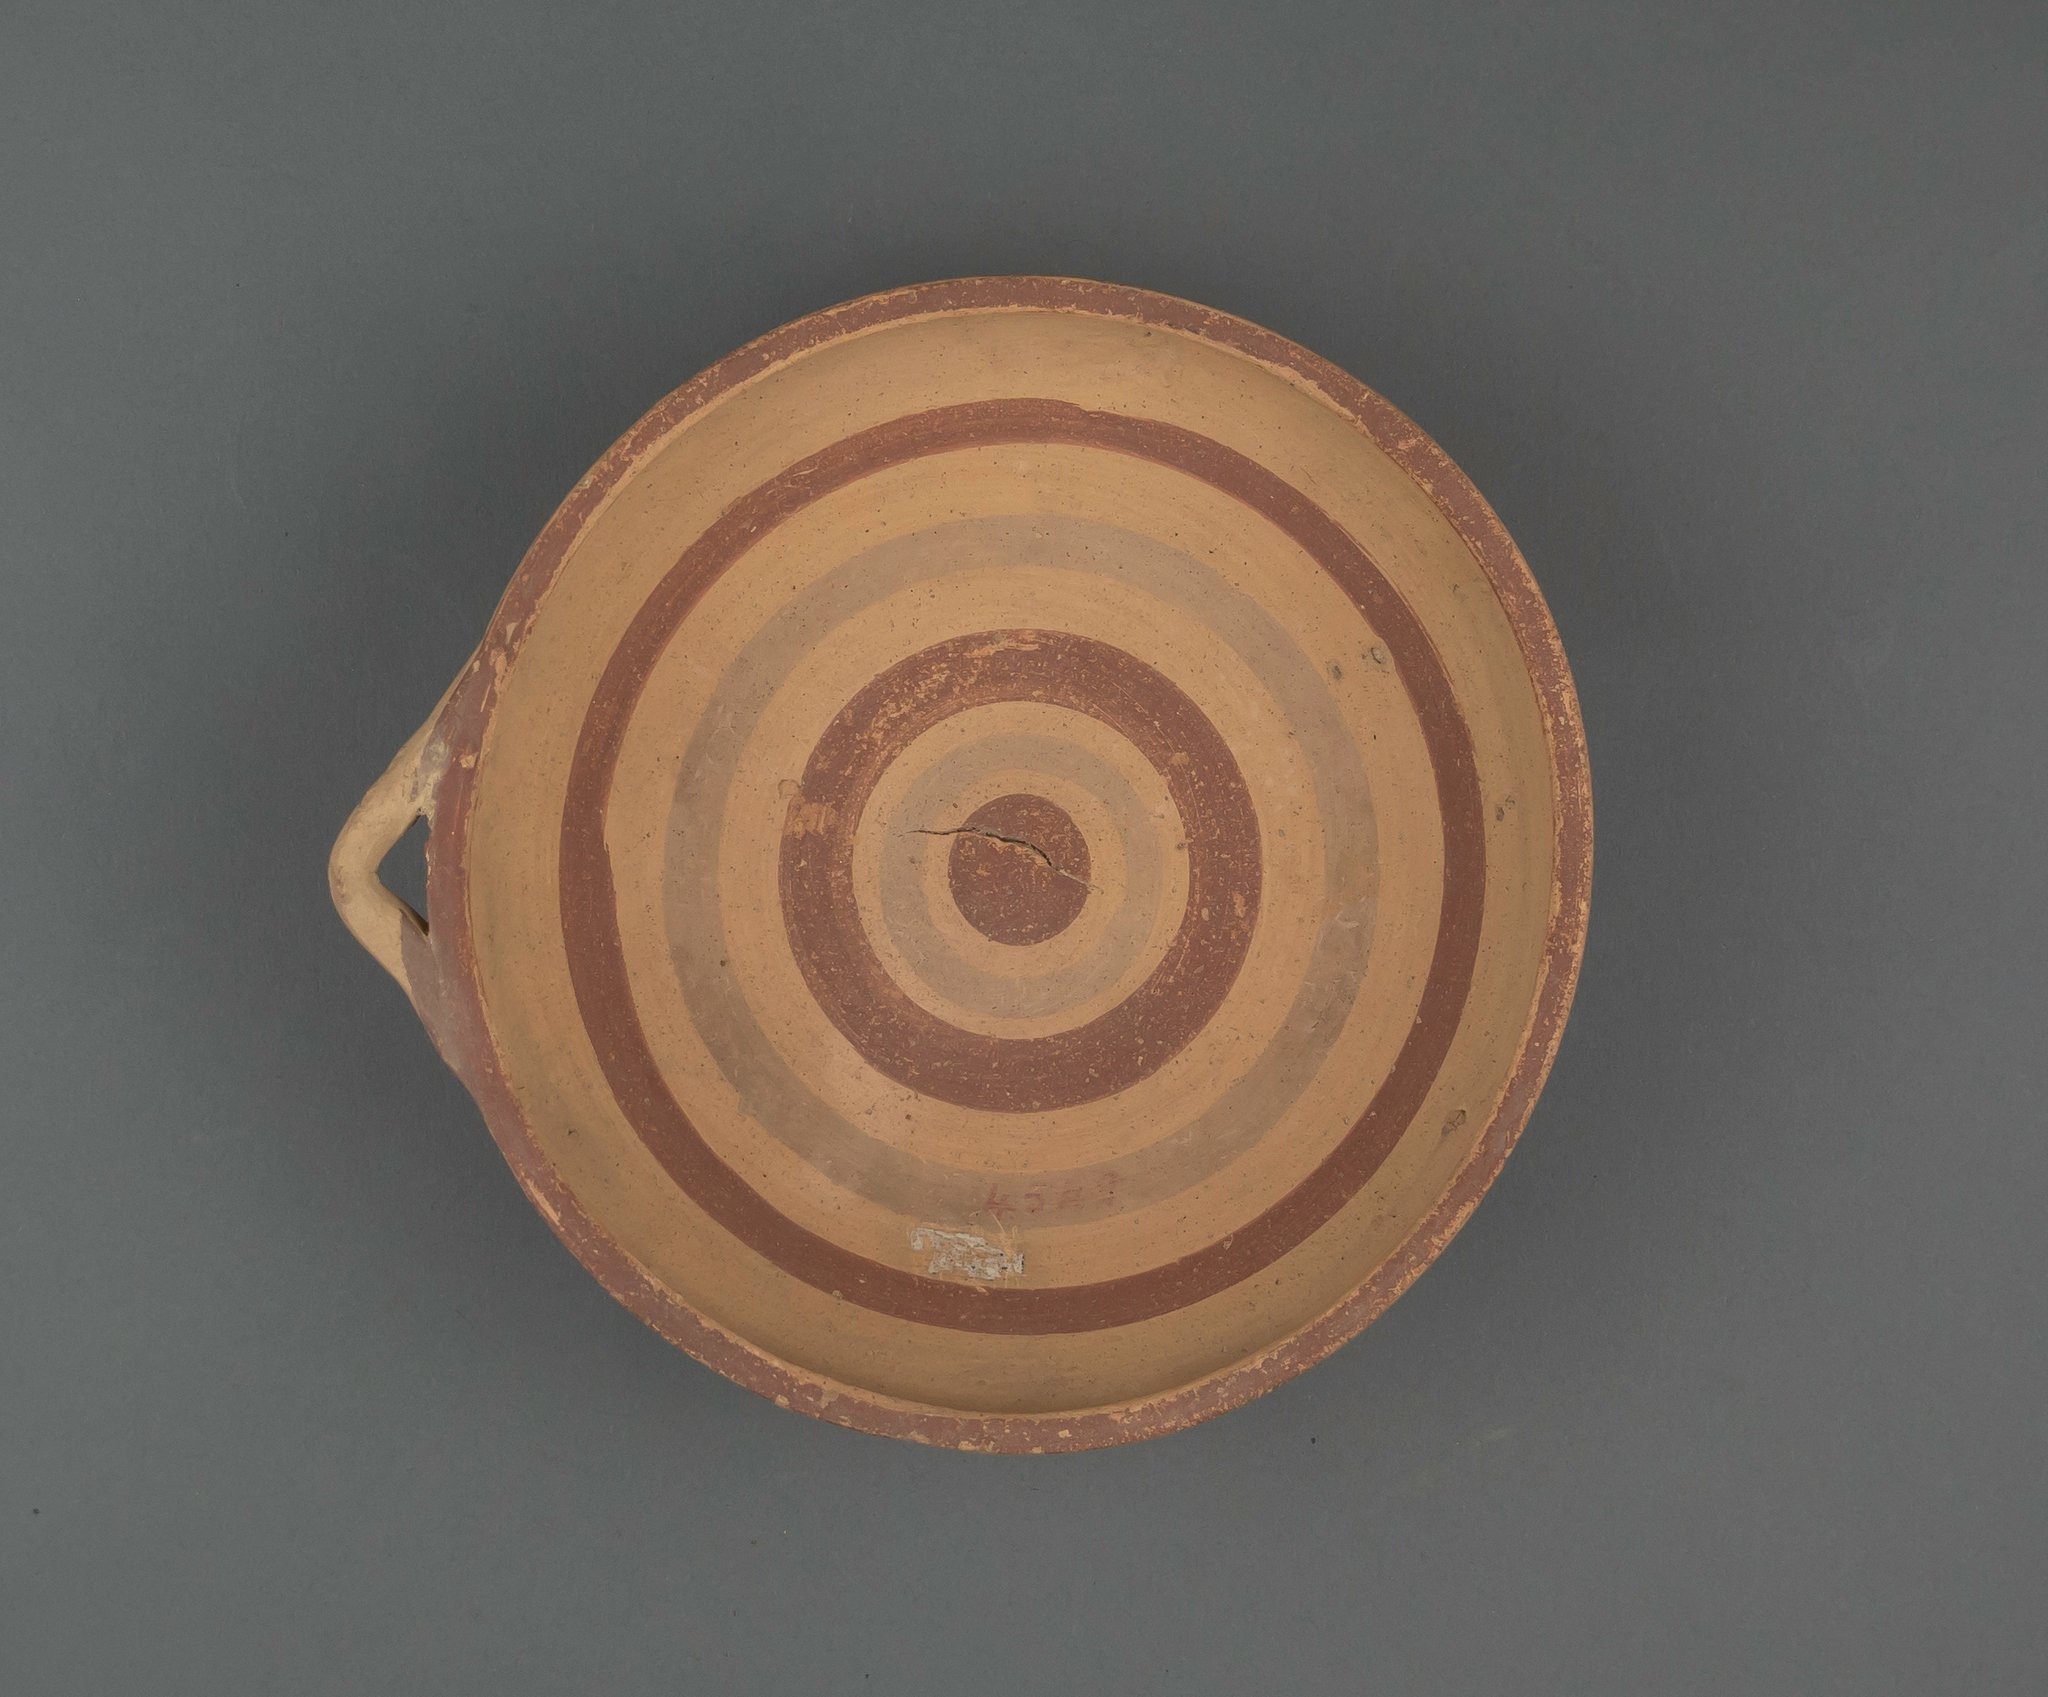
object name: bowl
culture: cypriot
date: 850-600 BCE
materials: terracotta